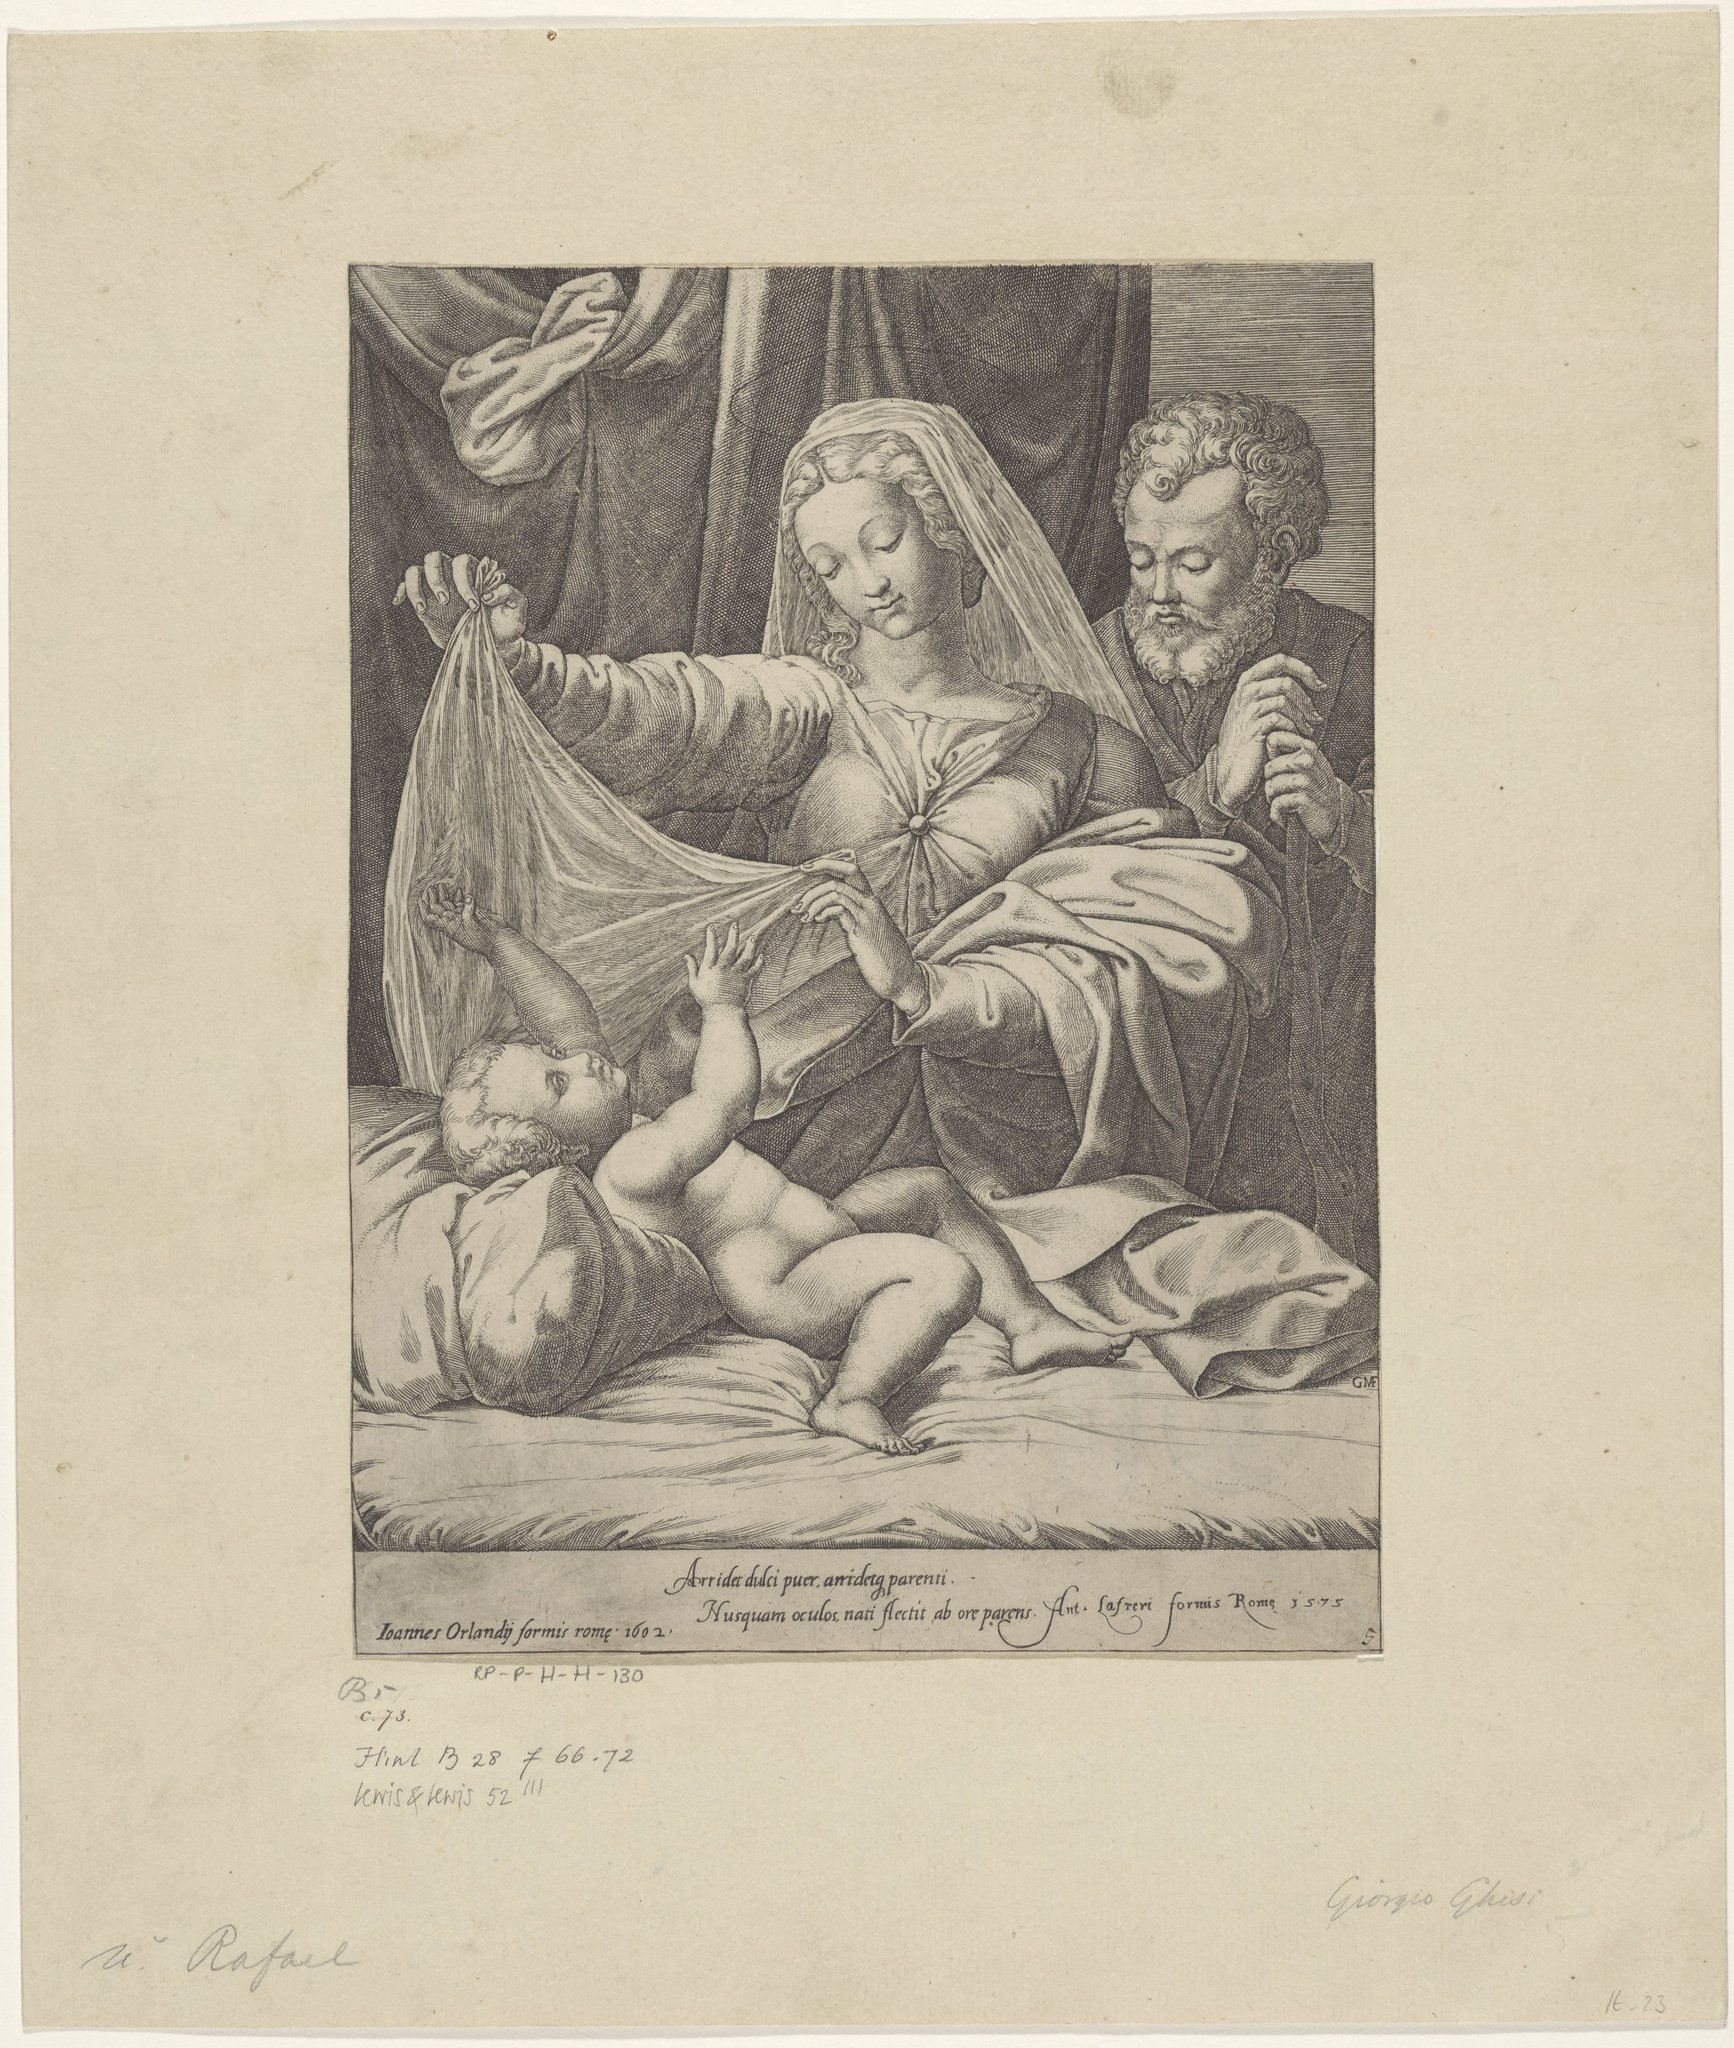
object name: print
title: Madonna van Loreto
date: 1575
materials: paper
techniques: engraving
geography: rome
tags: holy family, and derived representations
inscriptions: collector's mark: Lugt 10, collector's mark: Lugt 11, number: ‘5’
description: Het Christuskind ligt op een bed. Maria en Jozef staan naast het bed. Maria probeert Christus te bedekken met een doek.